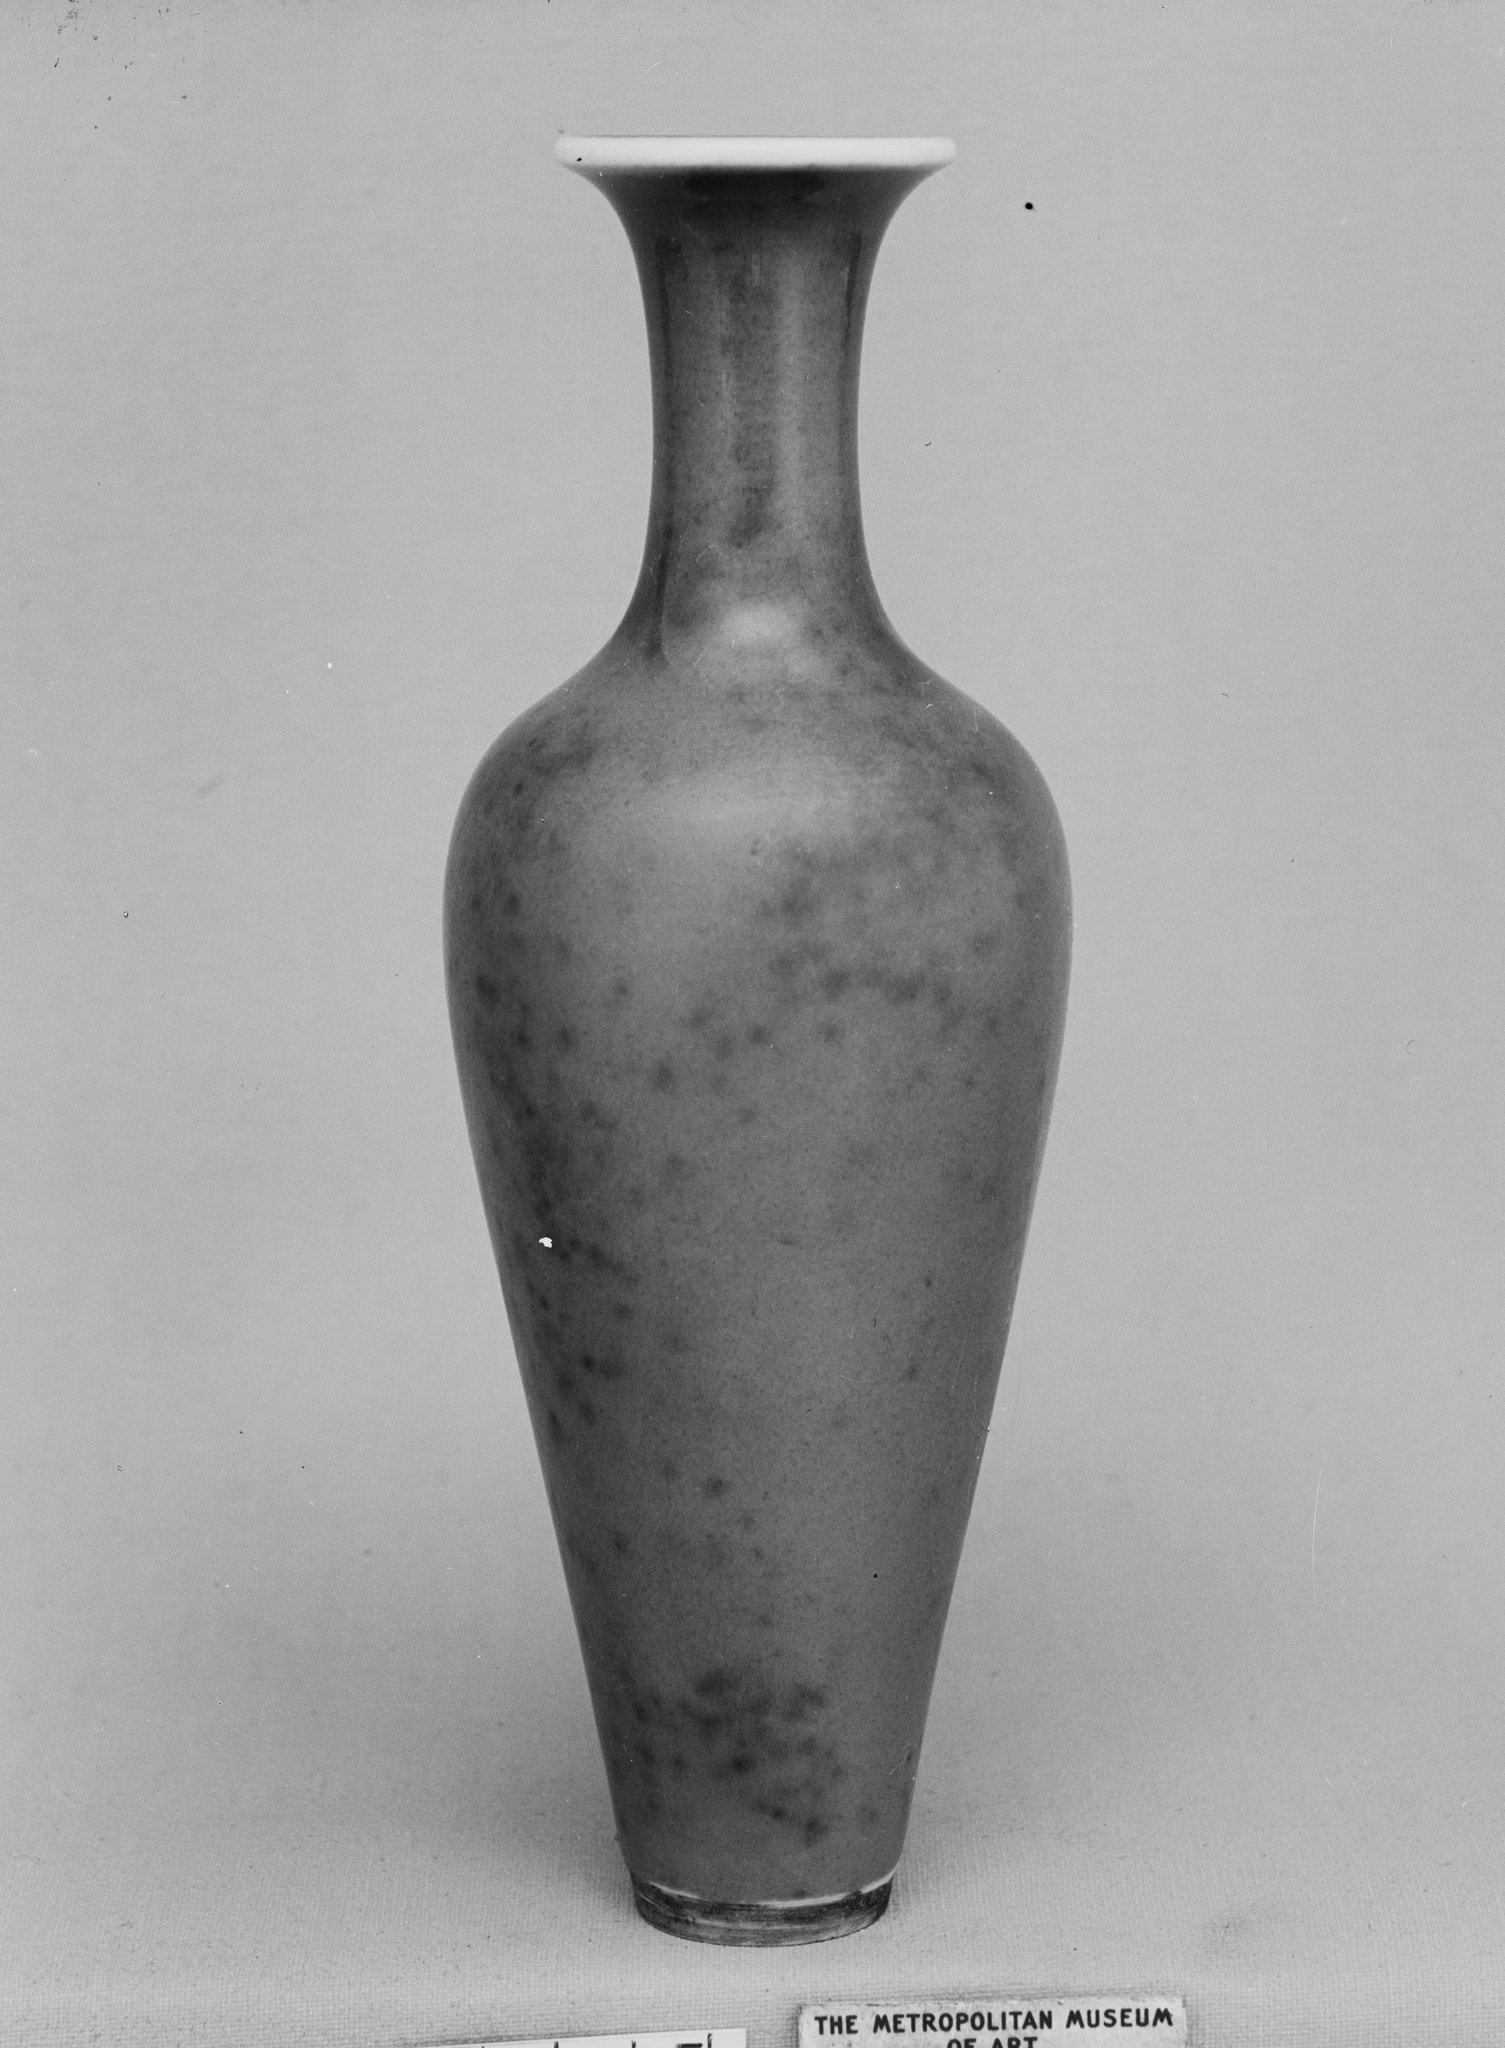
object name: vase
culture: chinese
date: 1662-1722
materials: porcelain